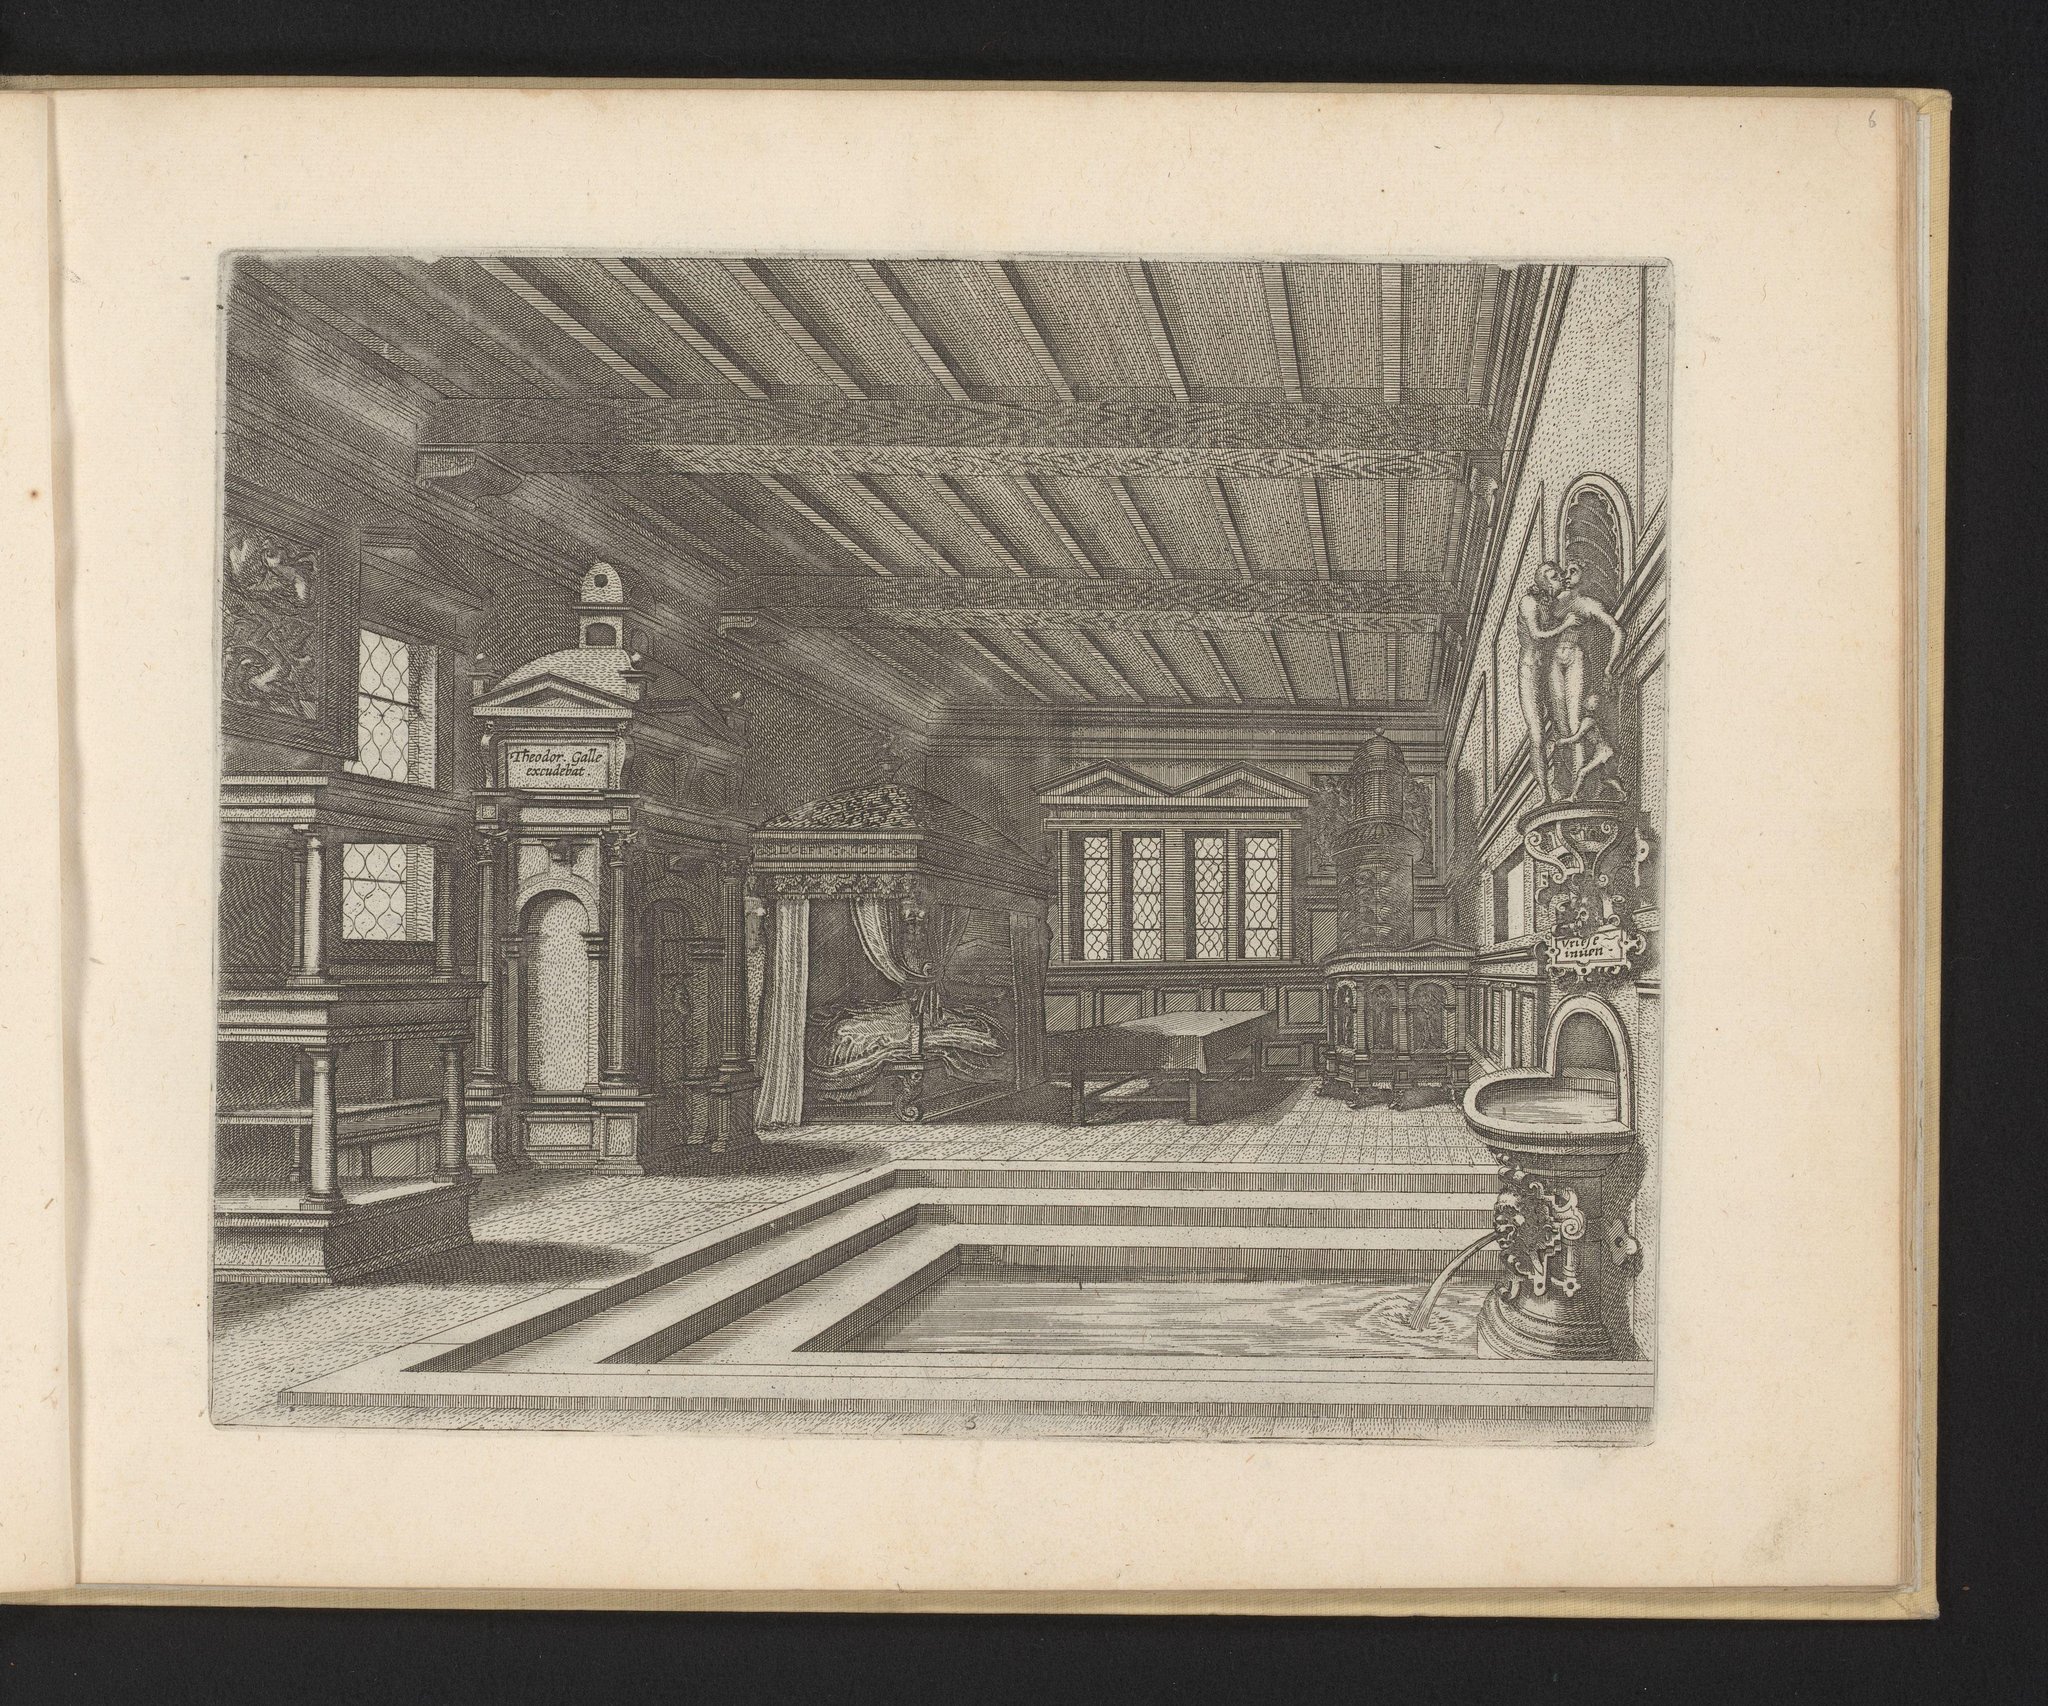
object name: album leaf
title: Variae architecturae formae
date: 1601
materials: paper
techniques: engraving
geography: antwerp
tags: jug and basin; wash-basin, interior of the house, bed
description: Interieur met een bed met baldakijn in de hoek en op de voorgrond een waterbassin met fontein. Boven de fontein een beeld van een minnekozend paar. De prent maakt deel uit van een album.